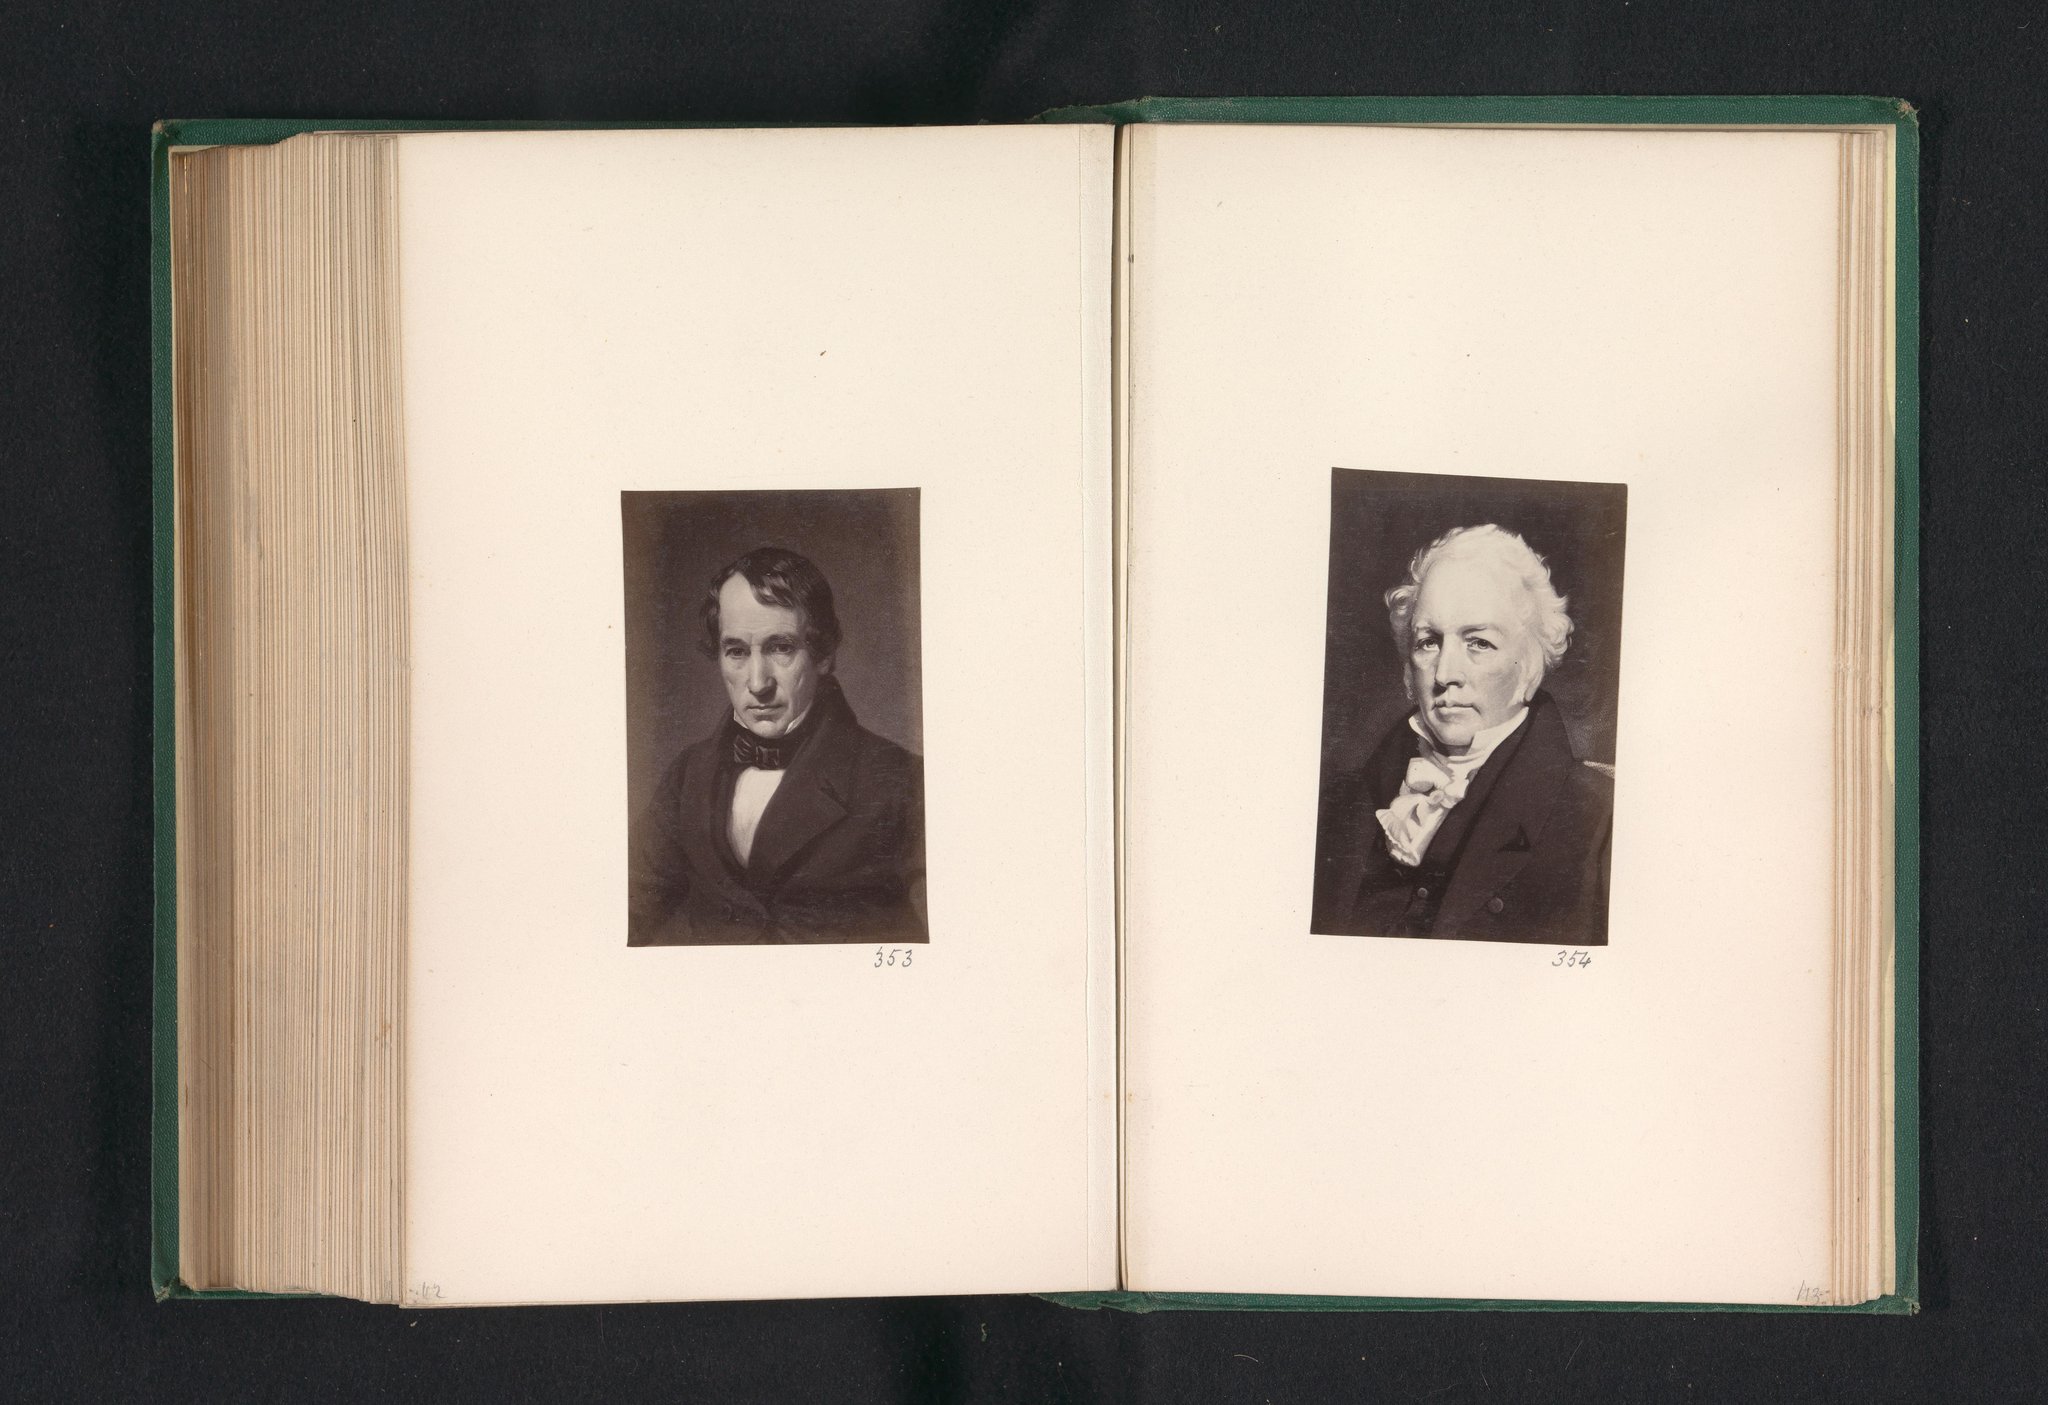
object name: photograph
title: Fotoreproductie van een schilderij, voorstellende een portret van Thomas Thomson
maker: thomas annan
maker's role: fotograaf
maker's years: 1829-1887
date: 1863-1868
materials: photographic support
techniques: albumen print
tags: historical persons (portraits and scenes from the life) (+ (full) bust portrait)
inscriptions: number: ‘353’